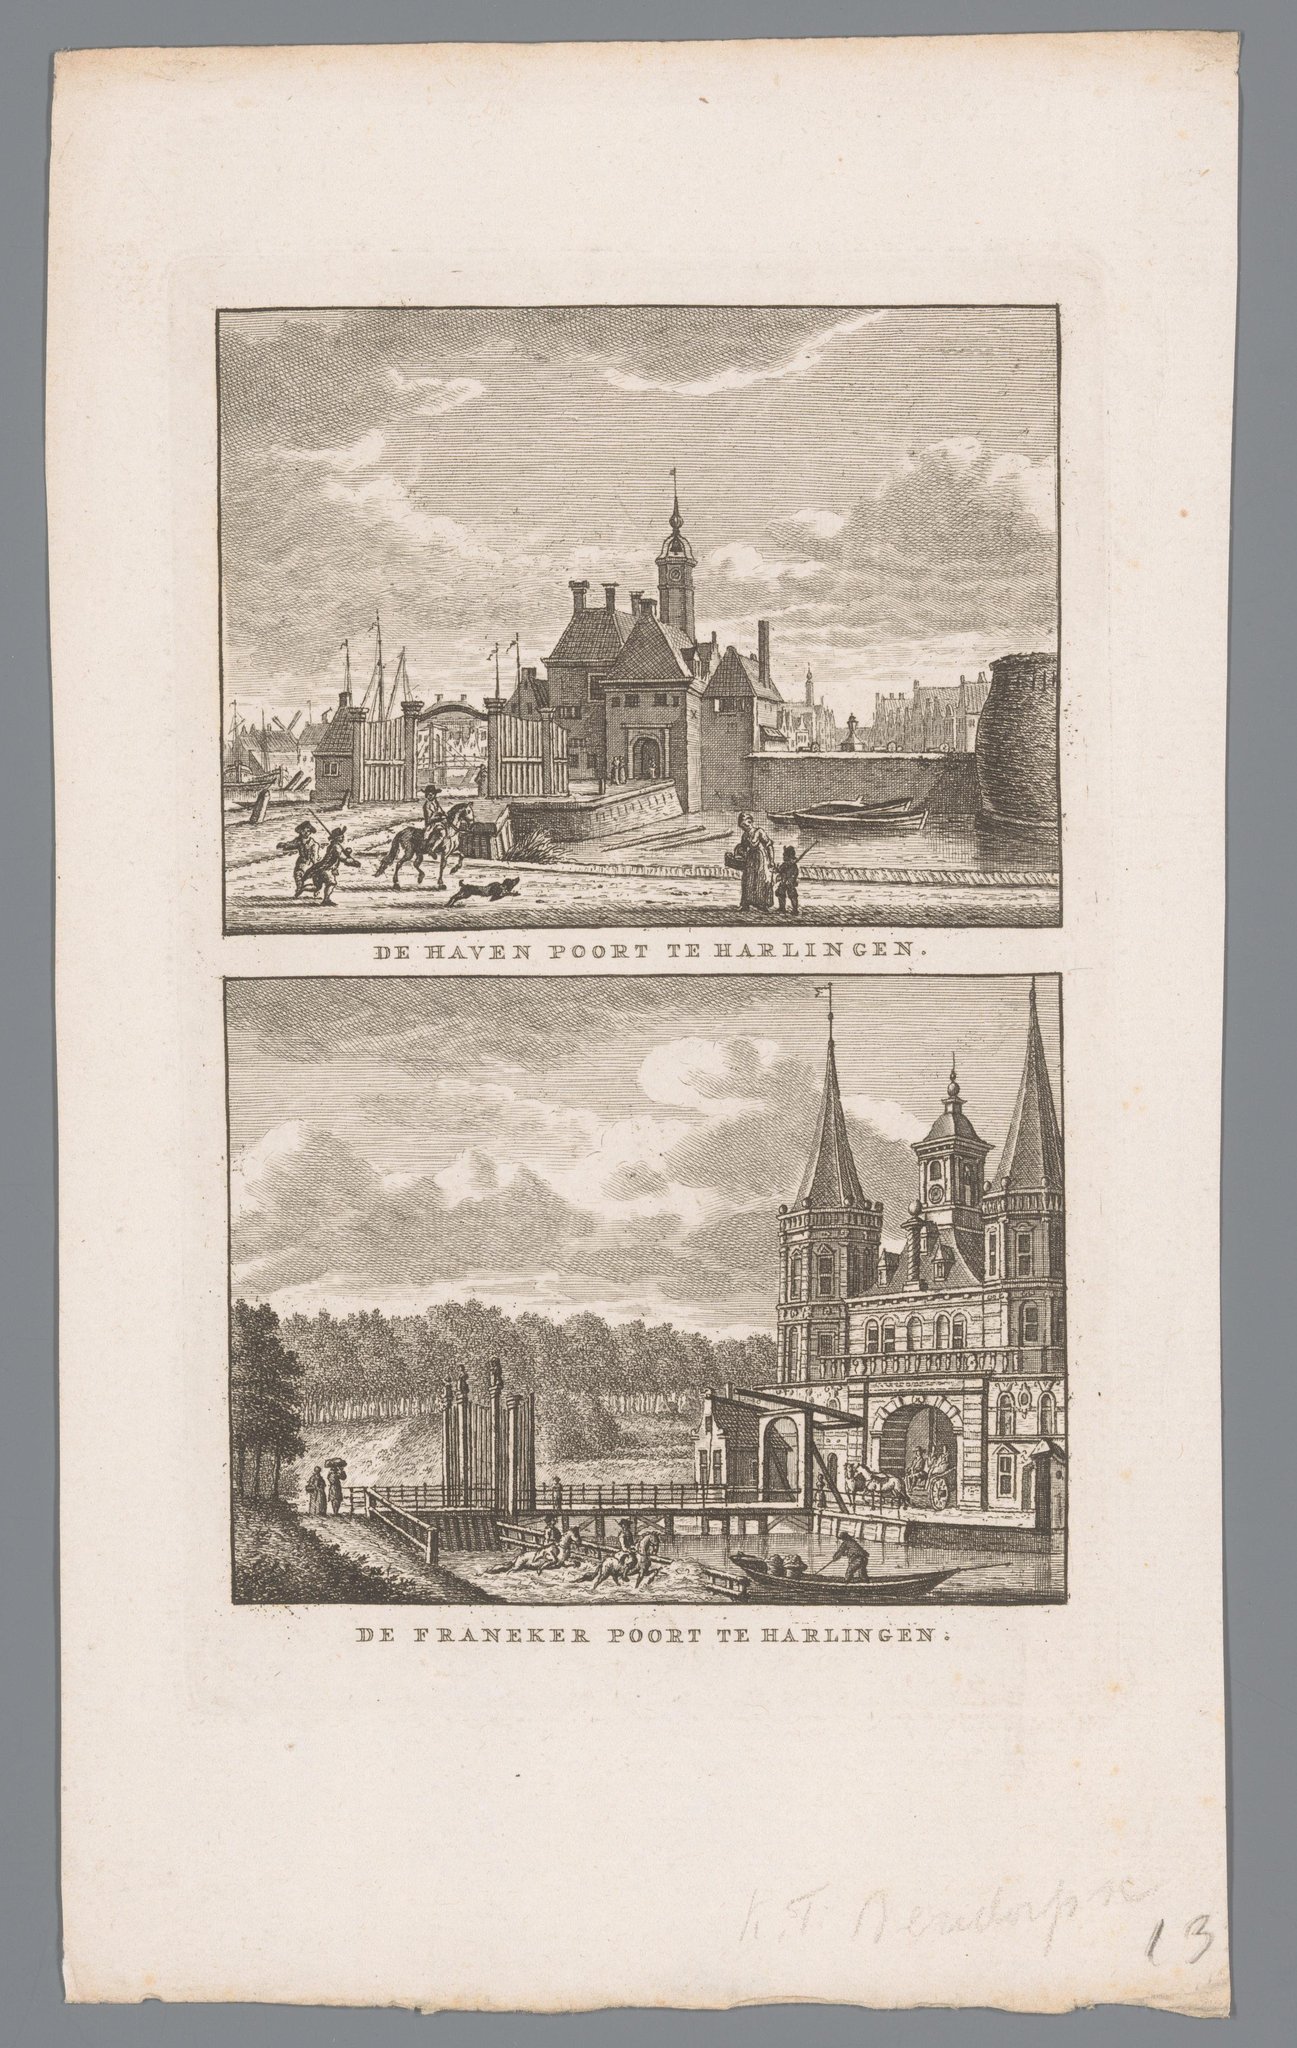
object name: print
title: Gezichten op de Havenpoort en de Franekerpoort te Harlingen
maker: carel frederik bendorp (i)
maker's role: print maker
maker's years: 1736-1814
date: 1786-1792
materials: paper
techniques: etching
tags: village, village-gate, harlingen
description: Prent uit: Vaderlandsche gezichten, of afbeeldingen van den tegenwoordigen staat der Vereenigde Nederlanden (…). Amsterdam: Hendrik Gartman, Willem Vermandel en Jan Willem Smit, 1786-1792. Uitgegeven in afleveringen met ieder een eigen bifolium en inhoudsopgave. Alle prenten in deze publicatie zijn gegraveerd door Carel Frederik Bendorp (I) en, in de meeste gevallen, gebaseerd op tekeningen van Jan Bulthuis.